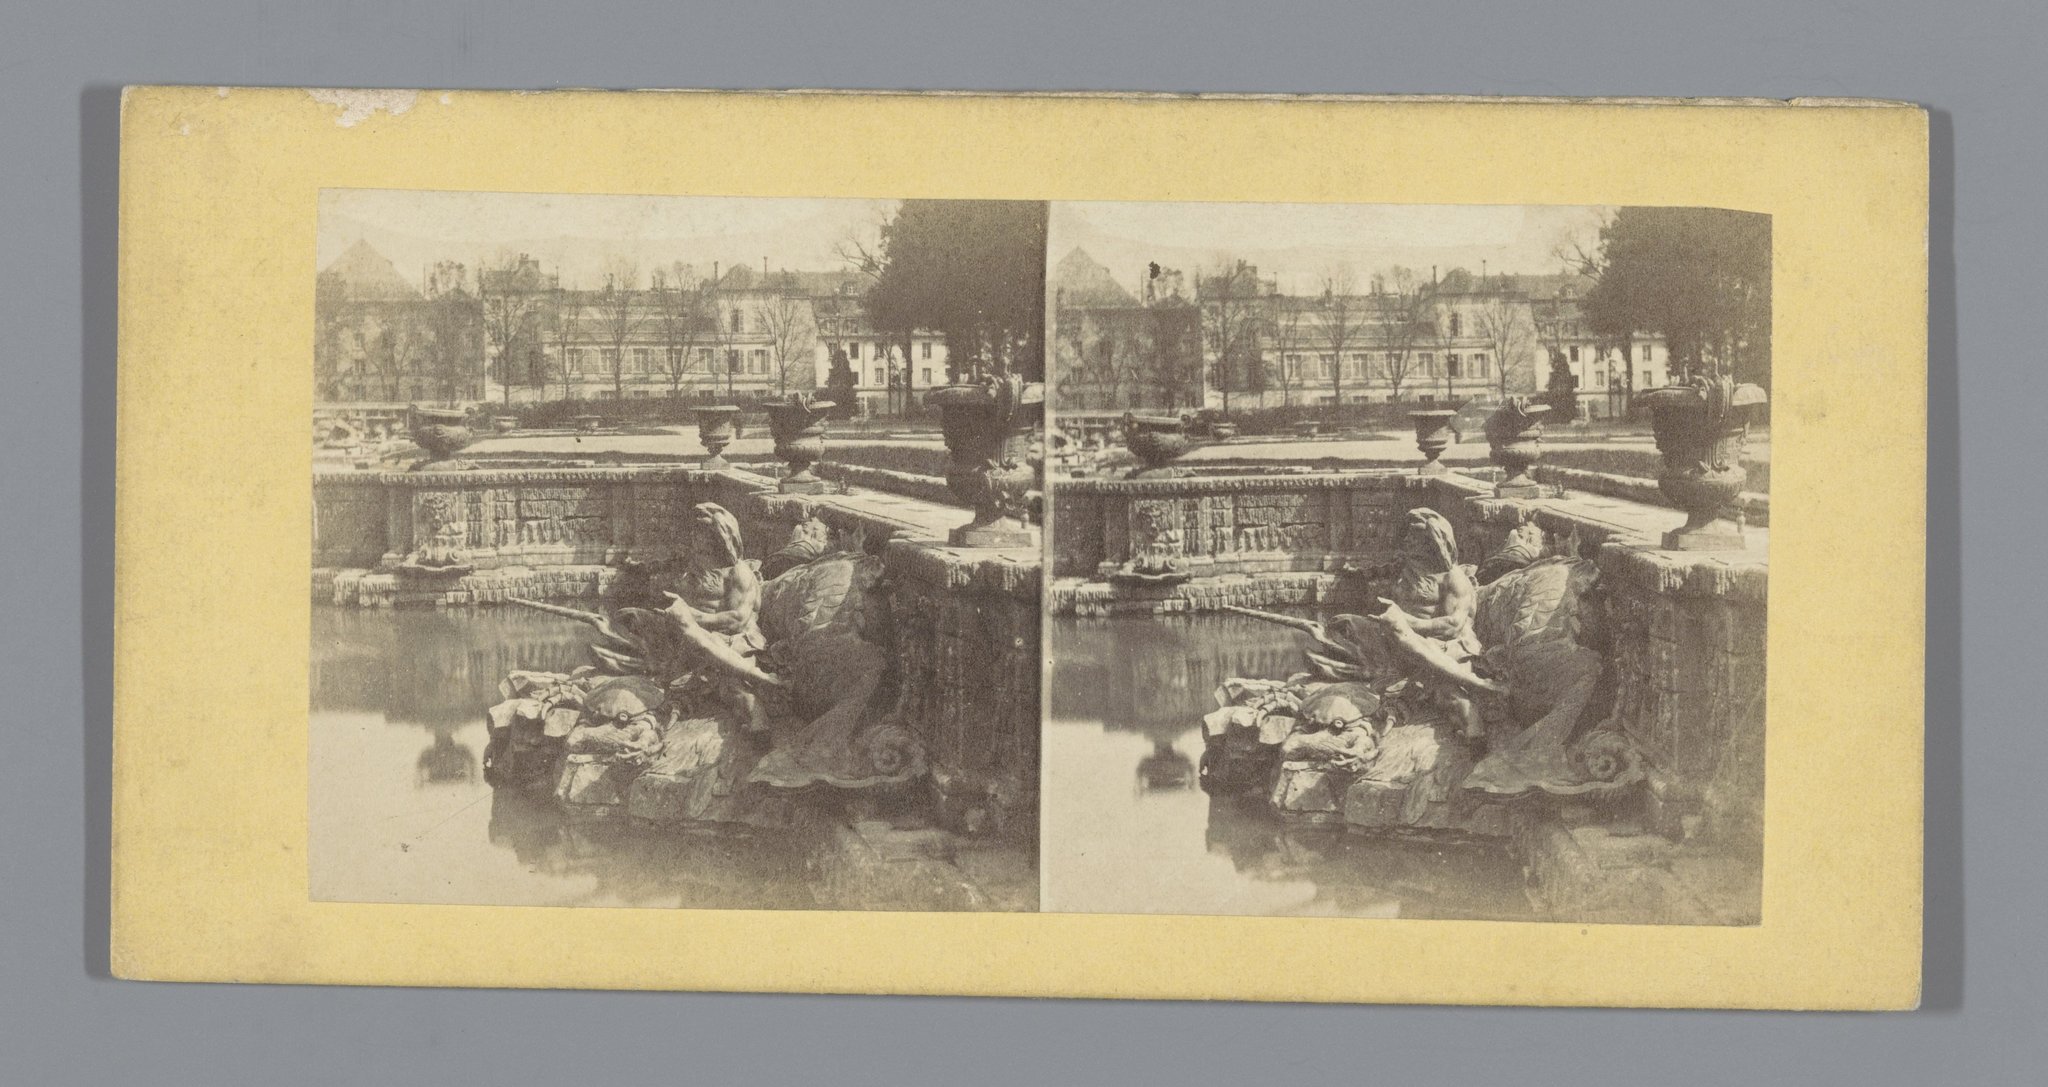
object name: stereograph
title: Deel van de Neptunusvijver in de Tuin van Versailles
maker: Anonymous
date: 1850-1875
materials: cardboard, photographic support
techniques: albumen print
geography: gardens of versailles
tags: sculpture, garden pond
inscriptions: number: ‘No 62. xv’